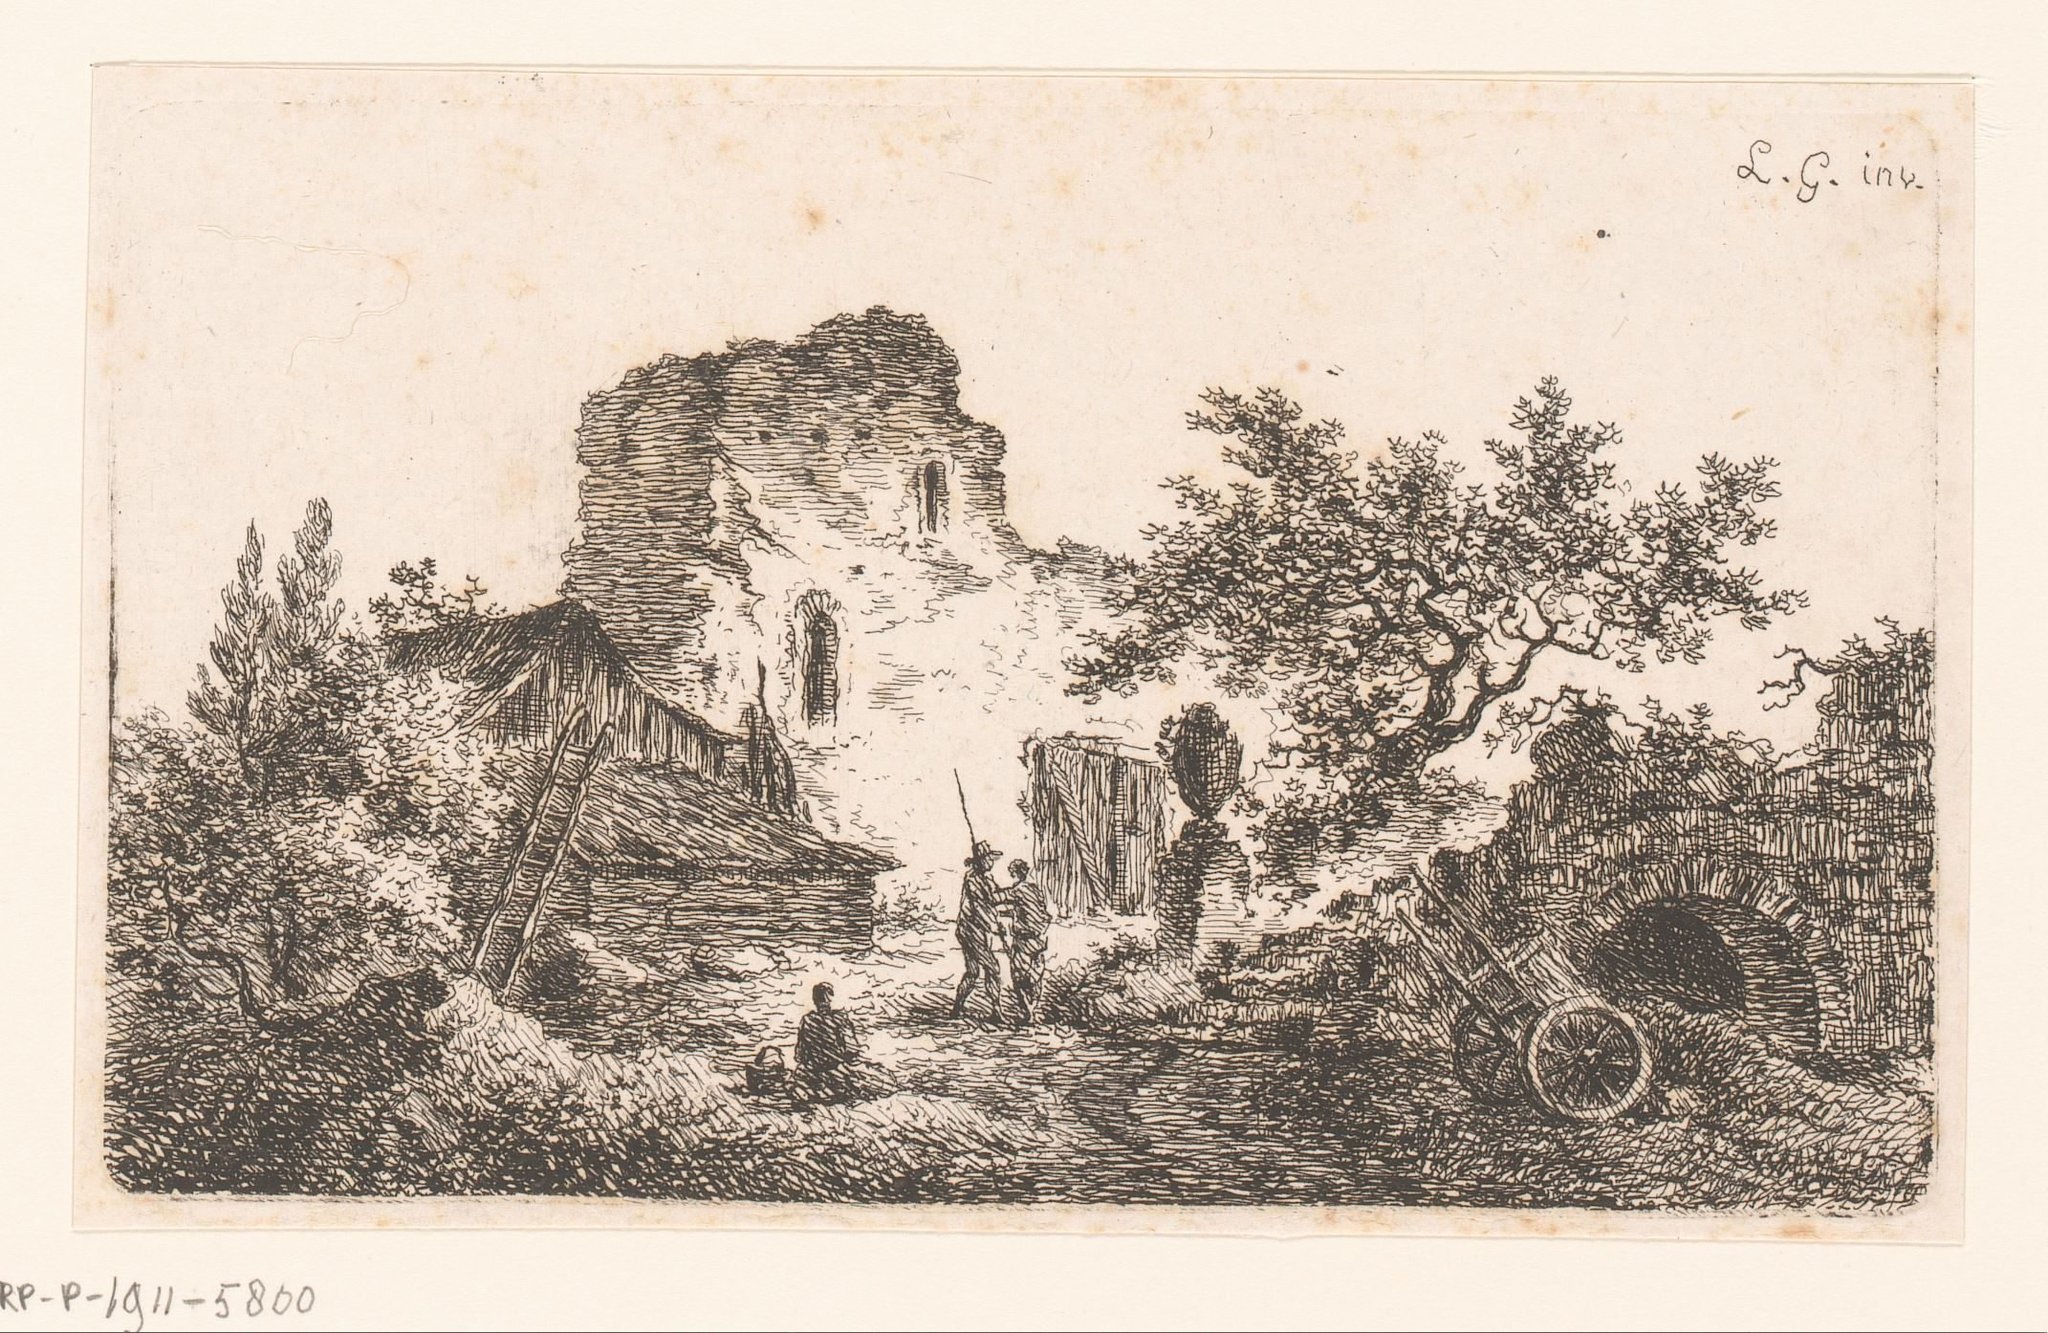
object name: print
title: Landschap met een boerderij bij een ruïne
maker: sauveur legros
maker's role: print maker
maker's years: 1754-1834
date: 1764-1834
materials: paper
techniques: etching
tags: landscape with ruins, farm or solitary house in landscape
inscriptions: collector's mark: Lugt 2228